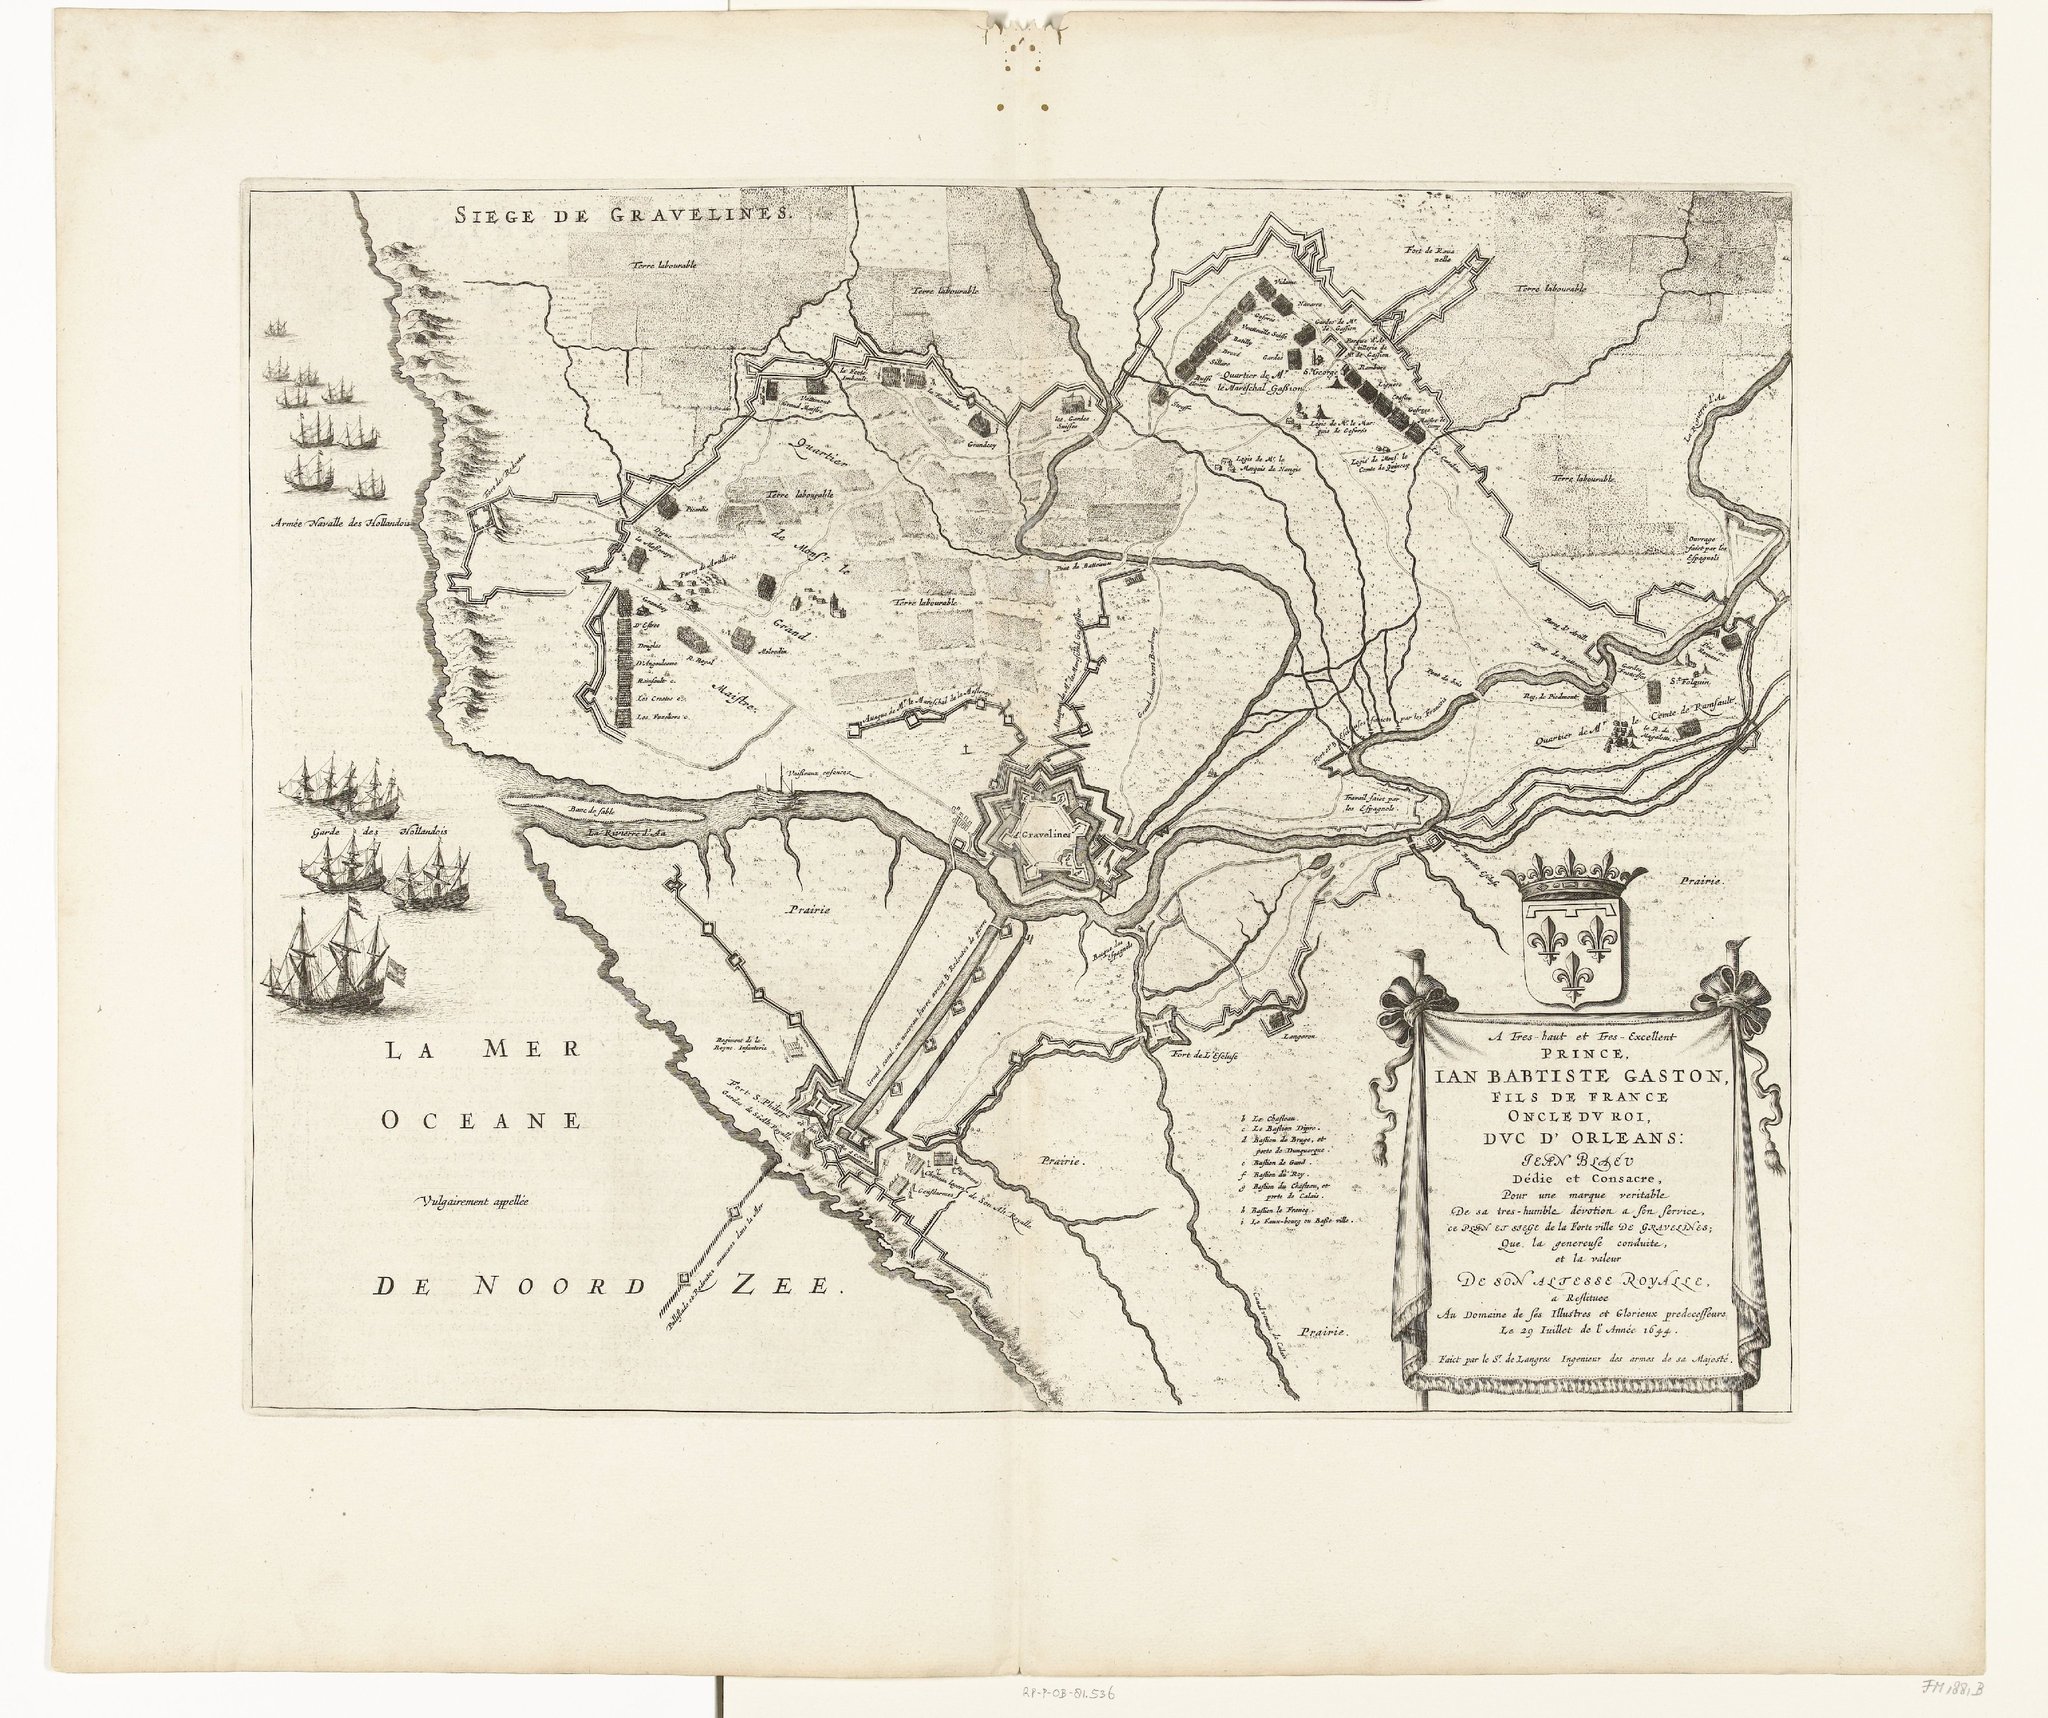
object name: print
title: Siege de Gravelines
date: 1652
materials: paper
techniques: engraving, etching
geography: amsterdam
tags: gaston jean-baptiste hertog van orléans, maps of separate countries or regions, siege, position war, armorial bearing, heraldry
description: Kaart van het beleg en de verovering van de stad Grevelingen door het Franse leger onder Gaston hertog van Orléans, 27 mei - 28 juli 1644. Plan van de versterkte stad met het omliggende land, links de haven geblokkeerd door Hollandse schepen. Rechtsonder een cartouche met de opdracht, met daarboven het wapen van Gaston van Orléans. Links van de cartouche een legenda b-i. Met Nederlandse tekst op verso.